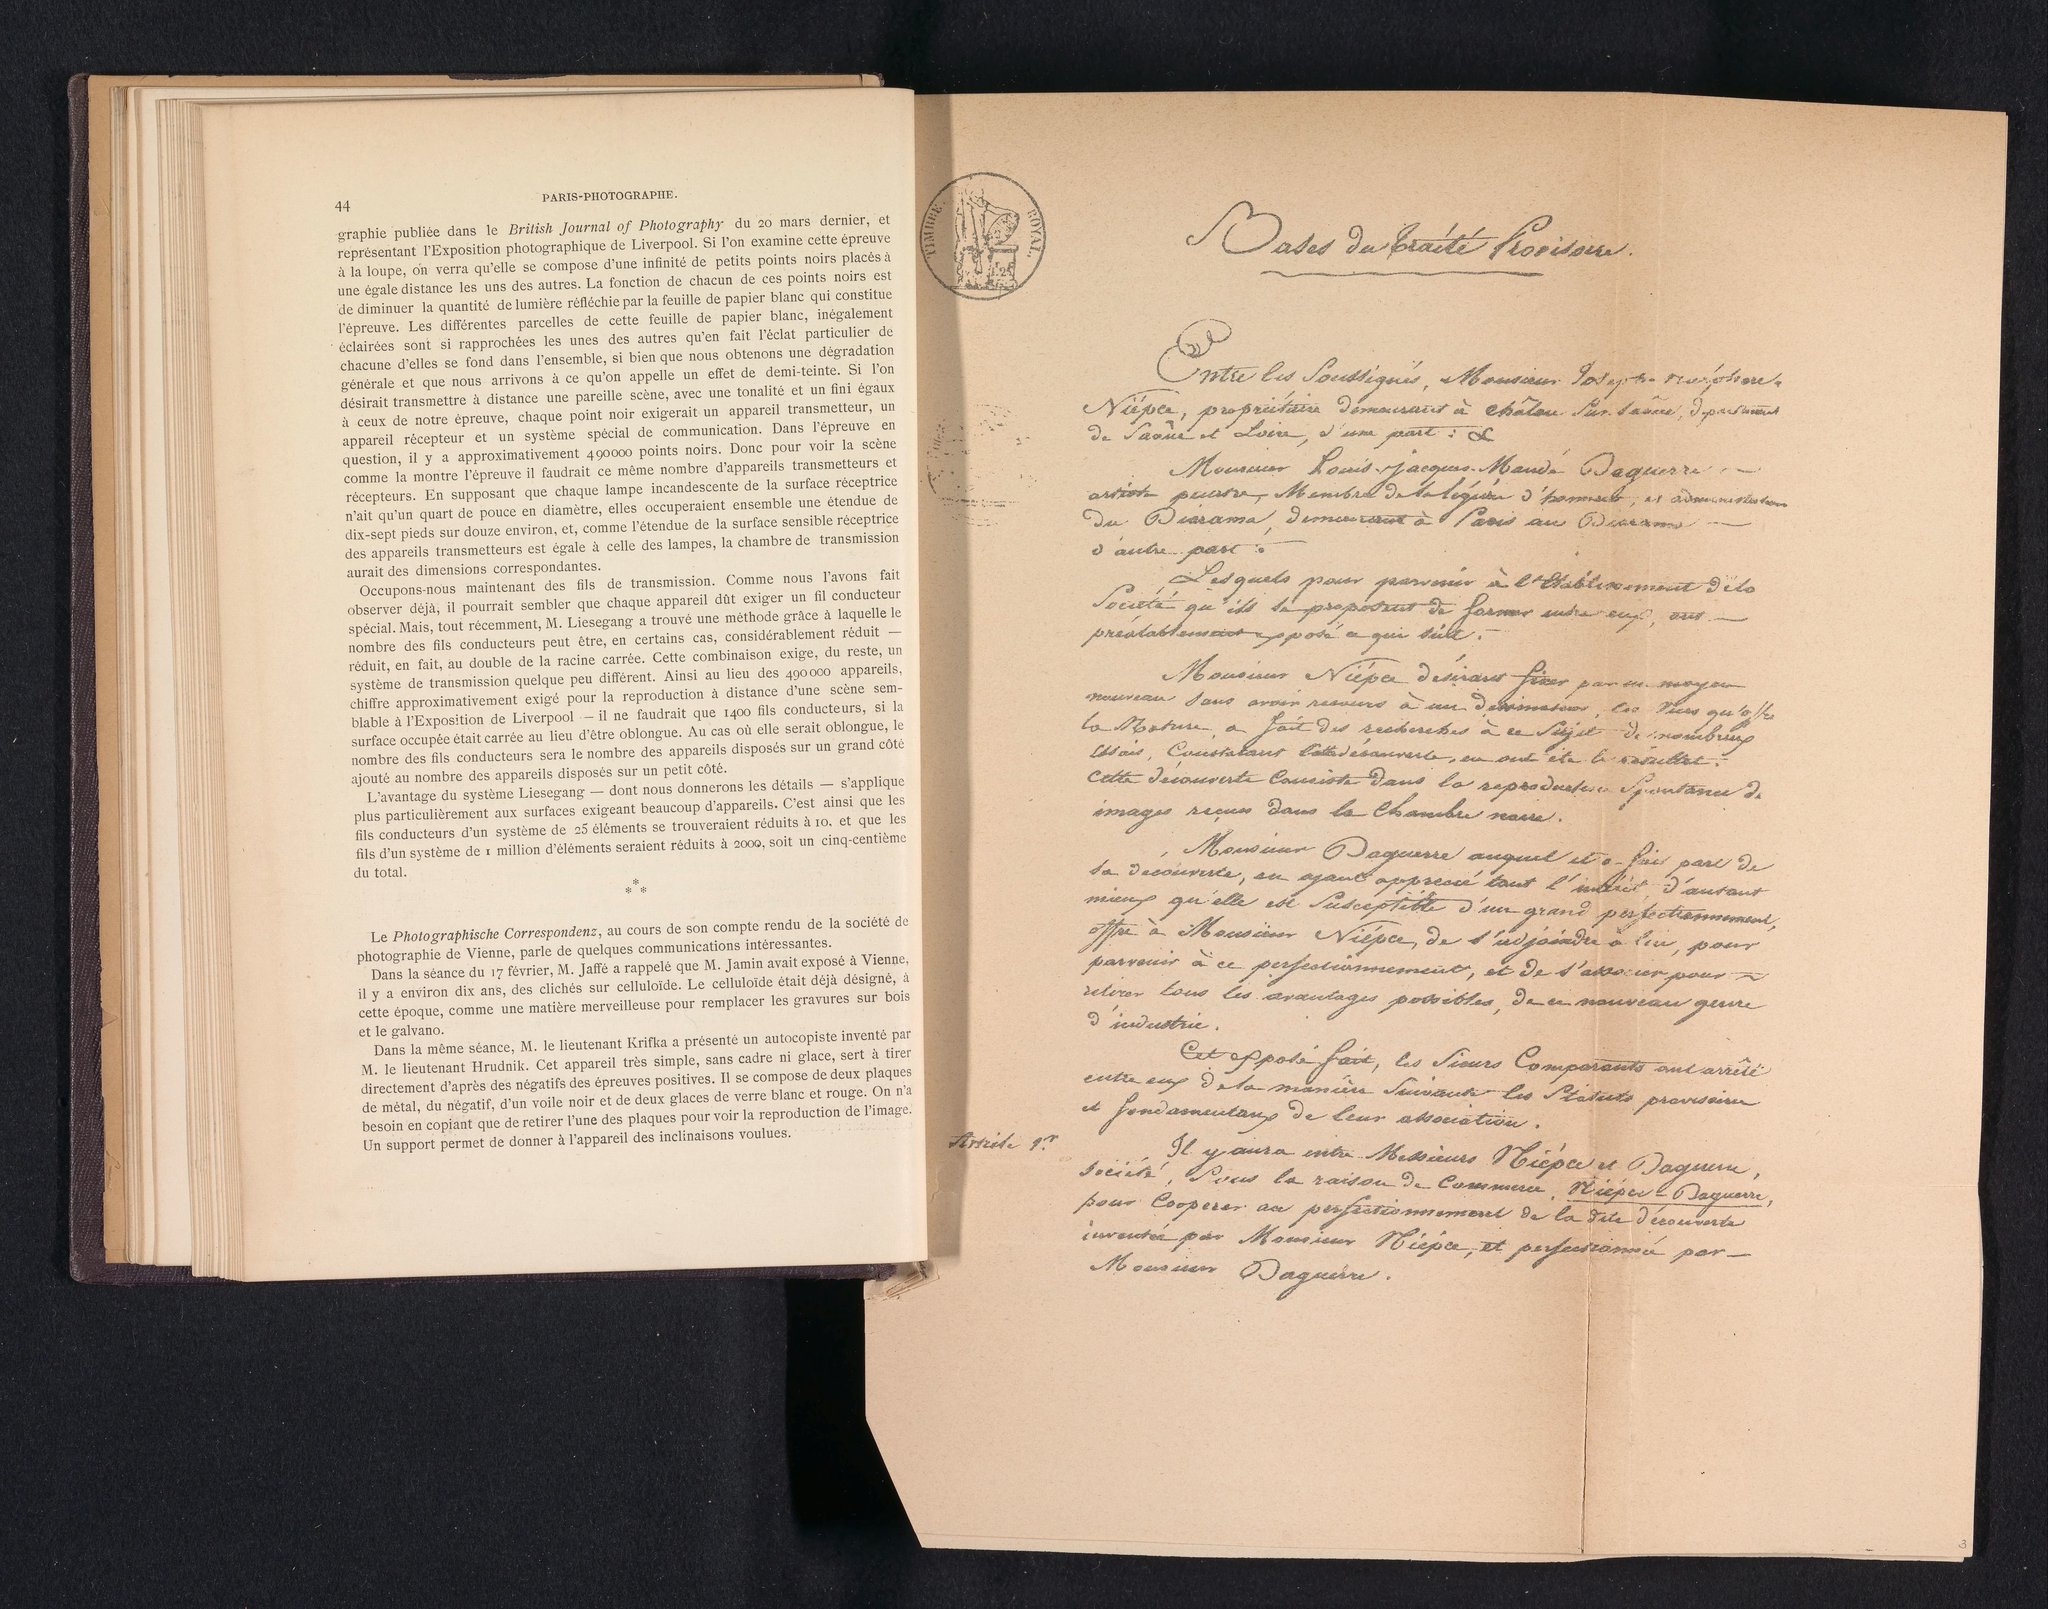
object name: reproduction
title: Fotoreproductie van de eerste pagina van het samenwerkingscontract tussen Louis Daguerre en Nicéphore Niépce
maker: l. landa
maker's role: printer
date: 1867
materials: paper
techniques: photolithography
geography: chalon-sur-saône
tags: handwriting, written text